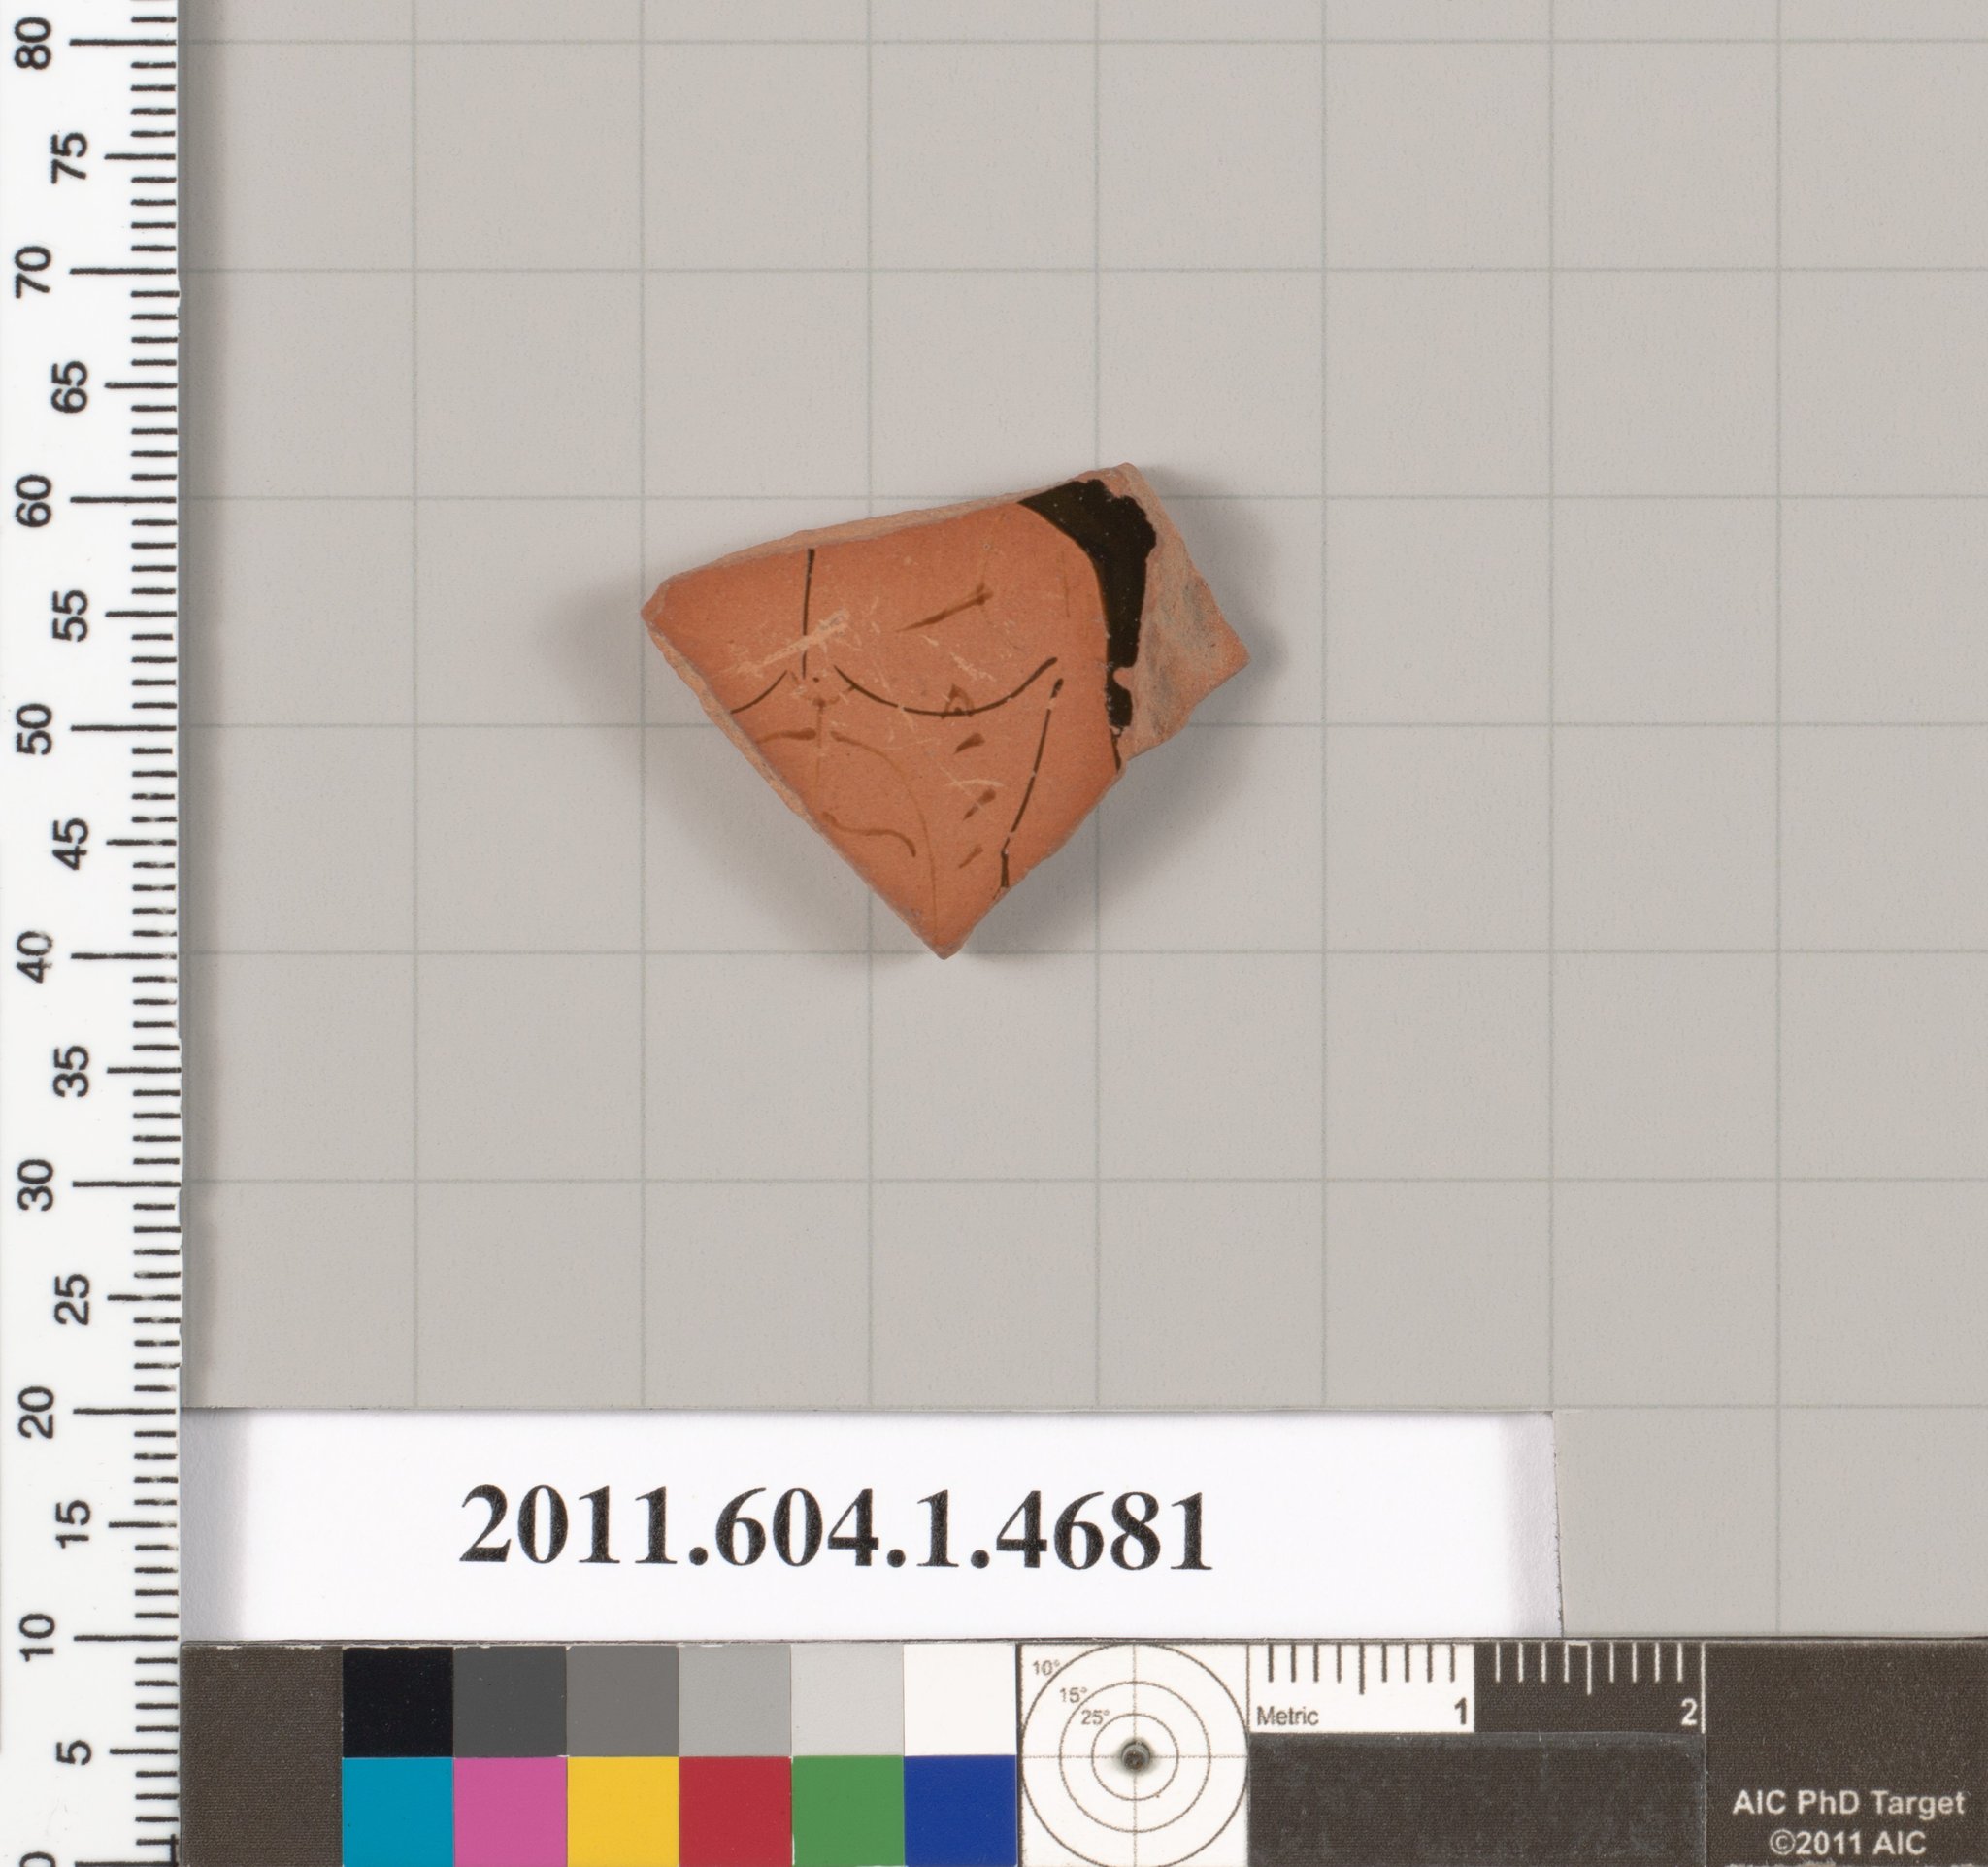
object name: kylix fragment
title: Terracotta fragment of a kylix (drinking cup)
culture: greek, attic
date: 475-451 BCE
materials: terracotta